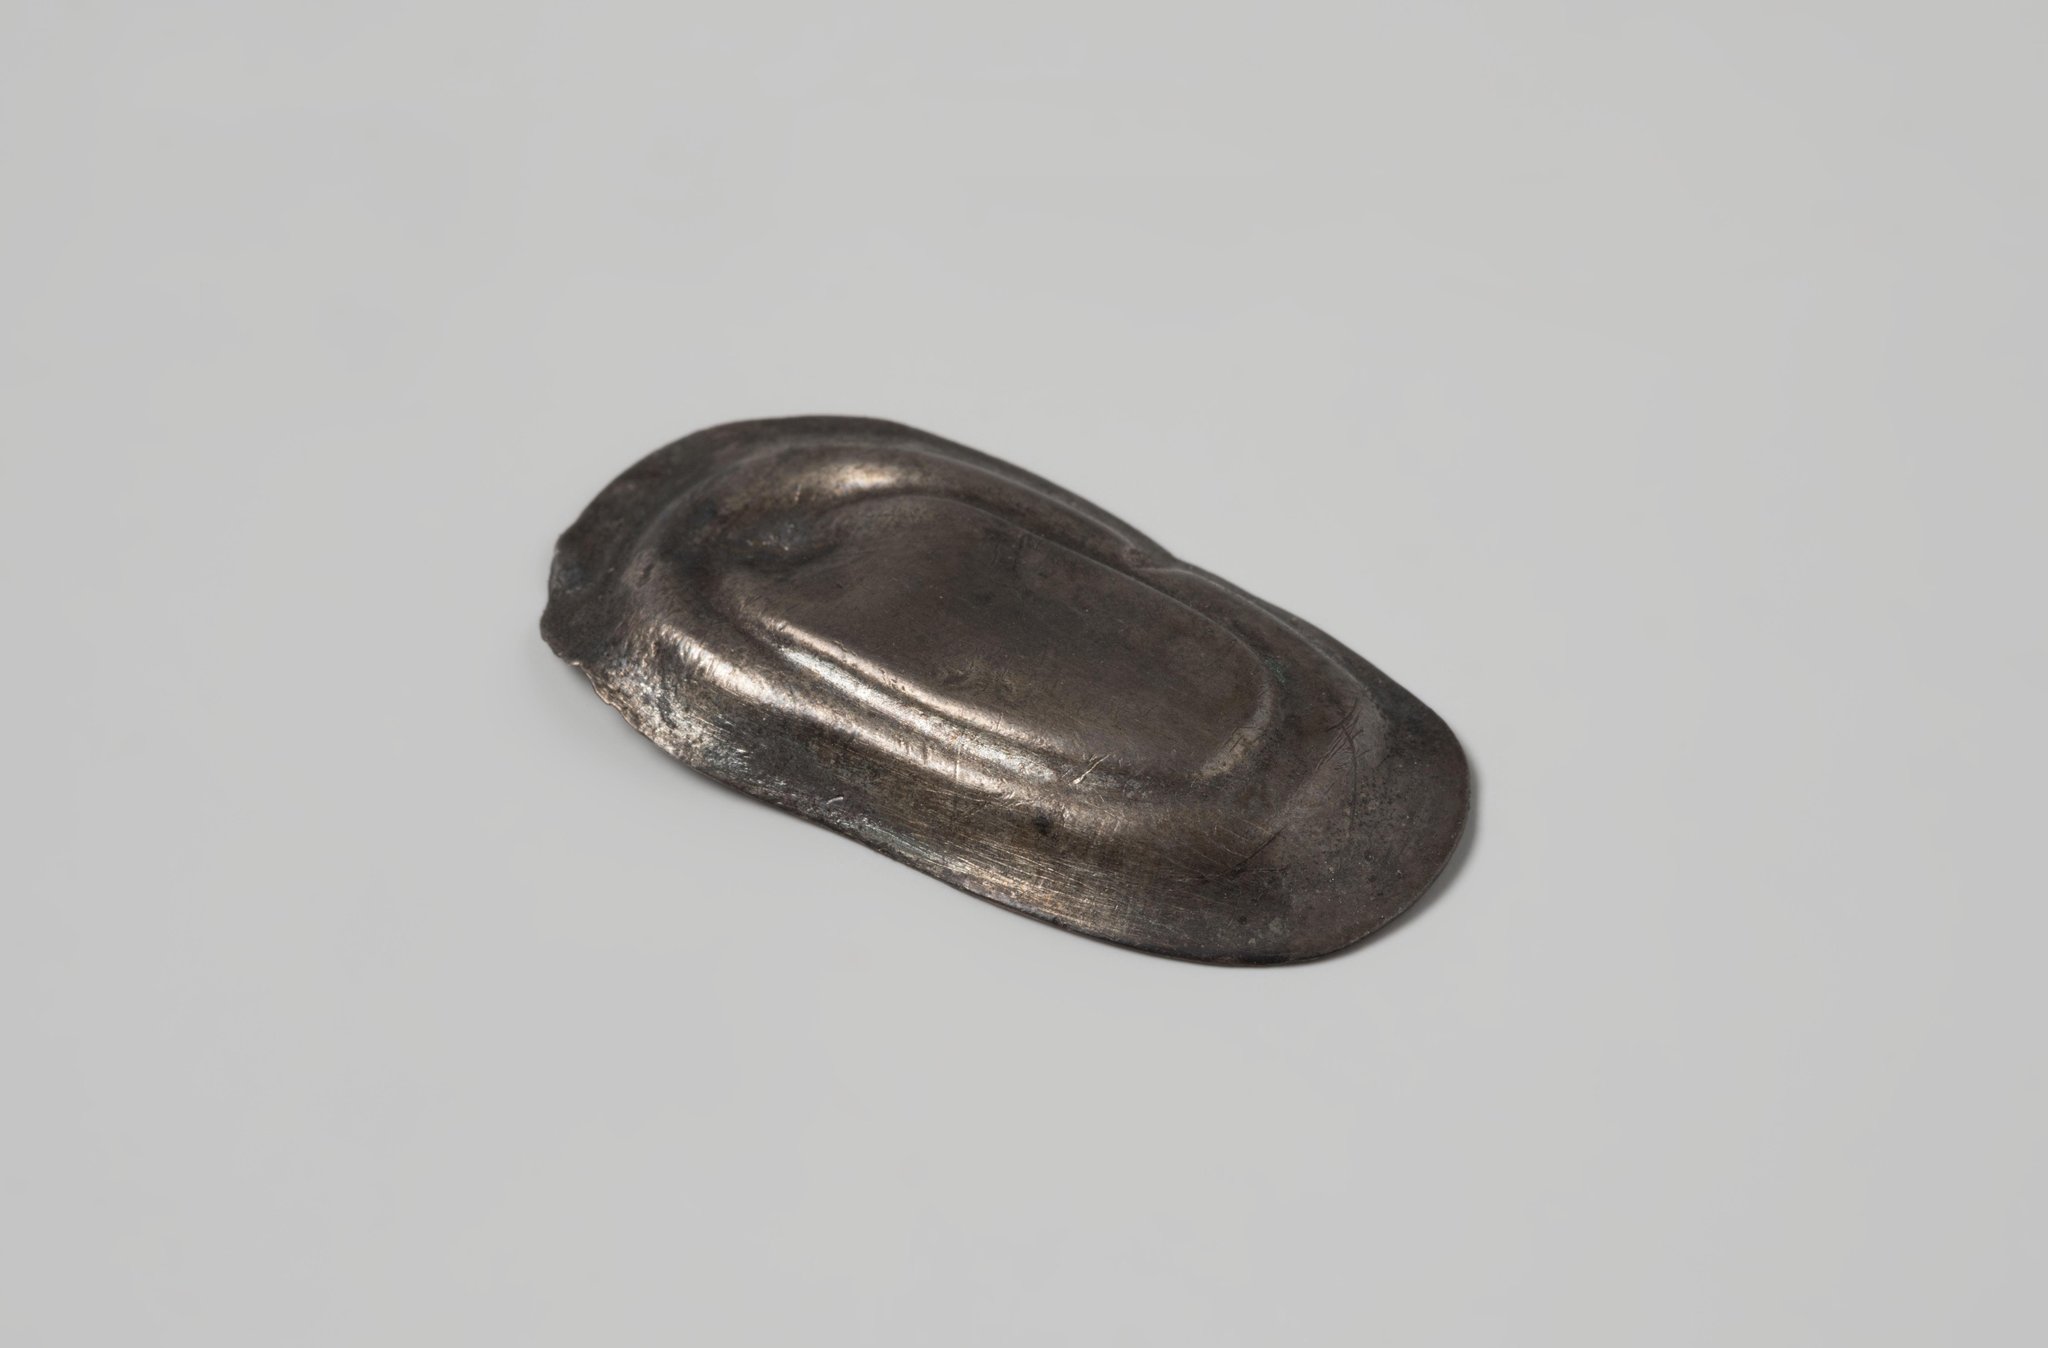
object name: beslag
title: Decoratief beslag uit het wrak van de Oost-Indiëvaarder Hollandia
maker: Anonymous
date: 1700-1743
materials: silver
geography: netherlands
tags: verenigde oostindische compagnie, hollandia (schip), annet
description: Fitting, decorative fitting or fragment; squashed, disc-shaped, oval, domed, stepped.